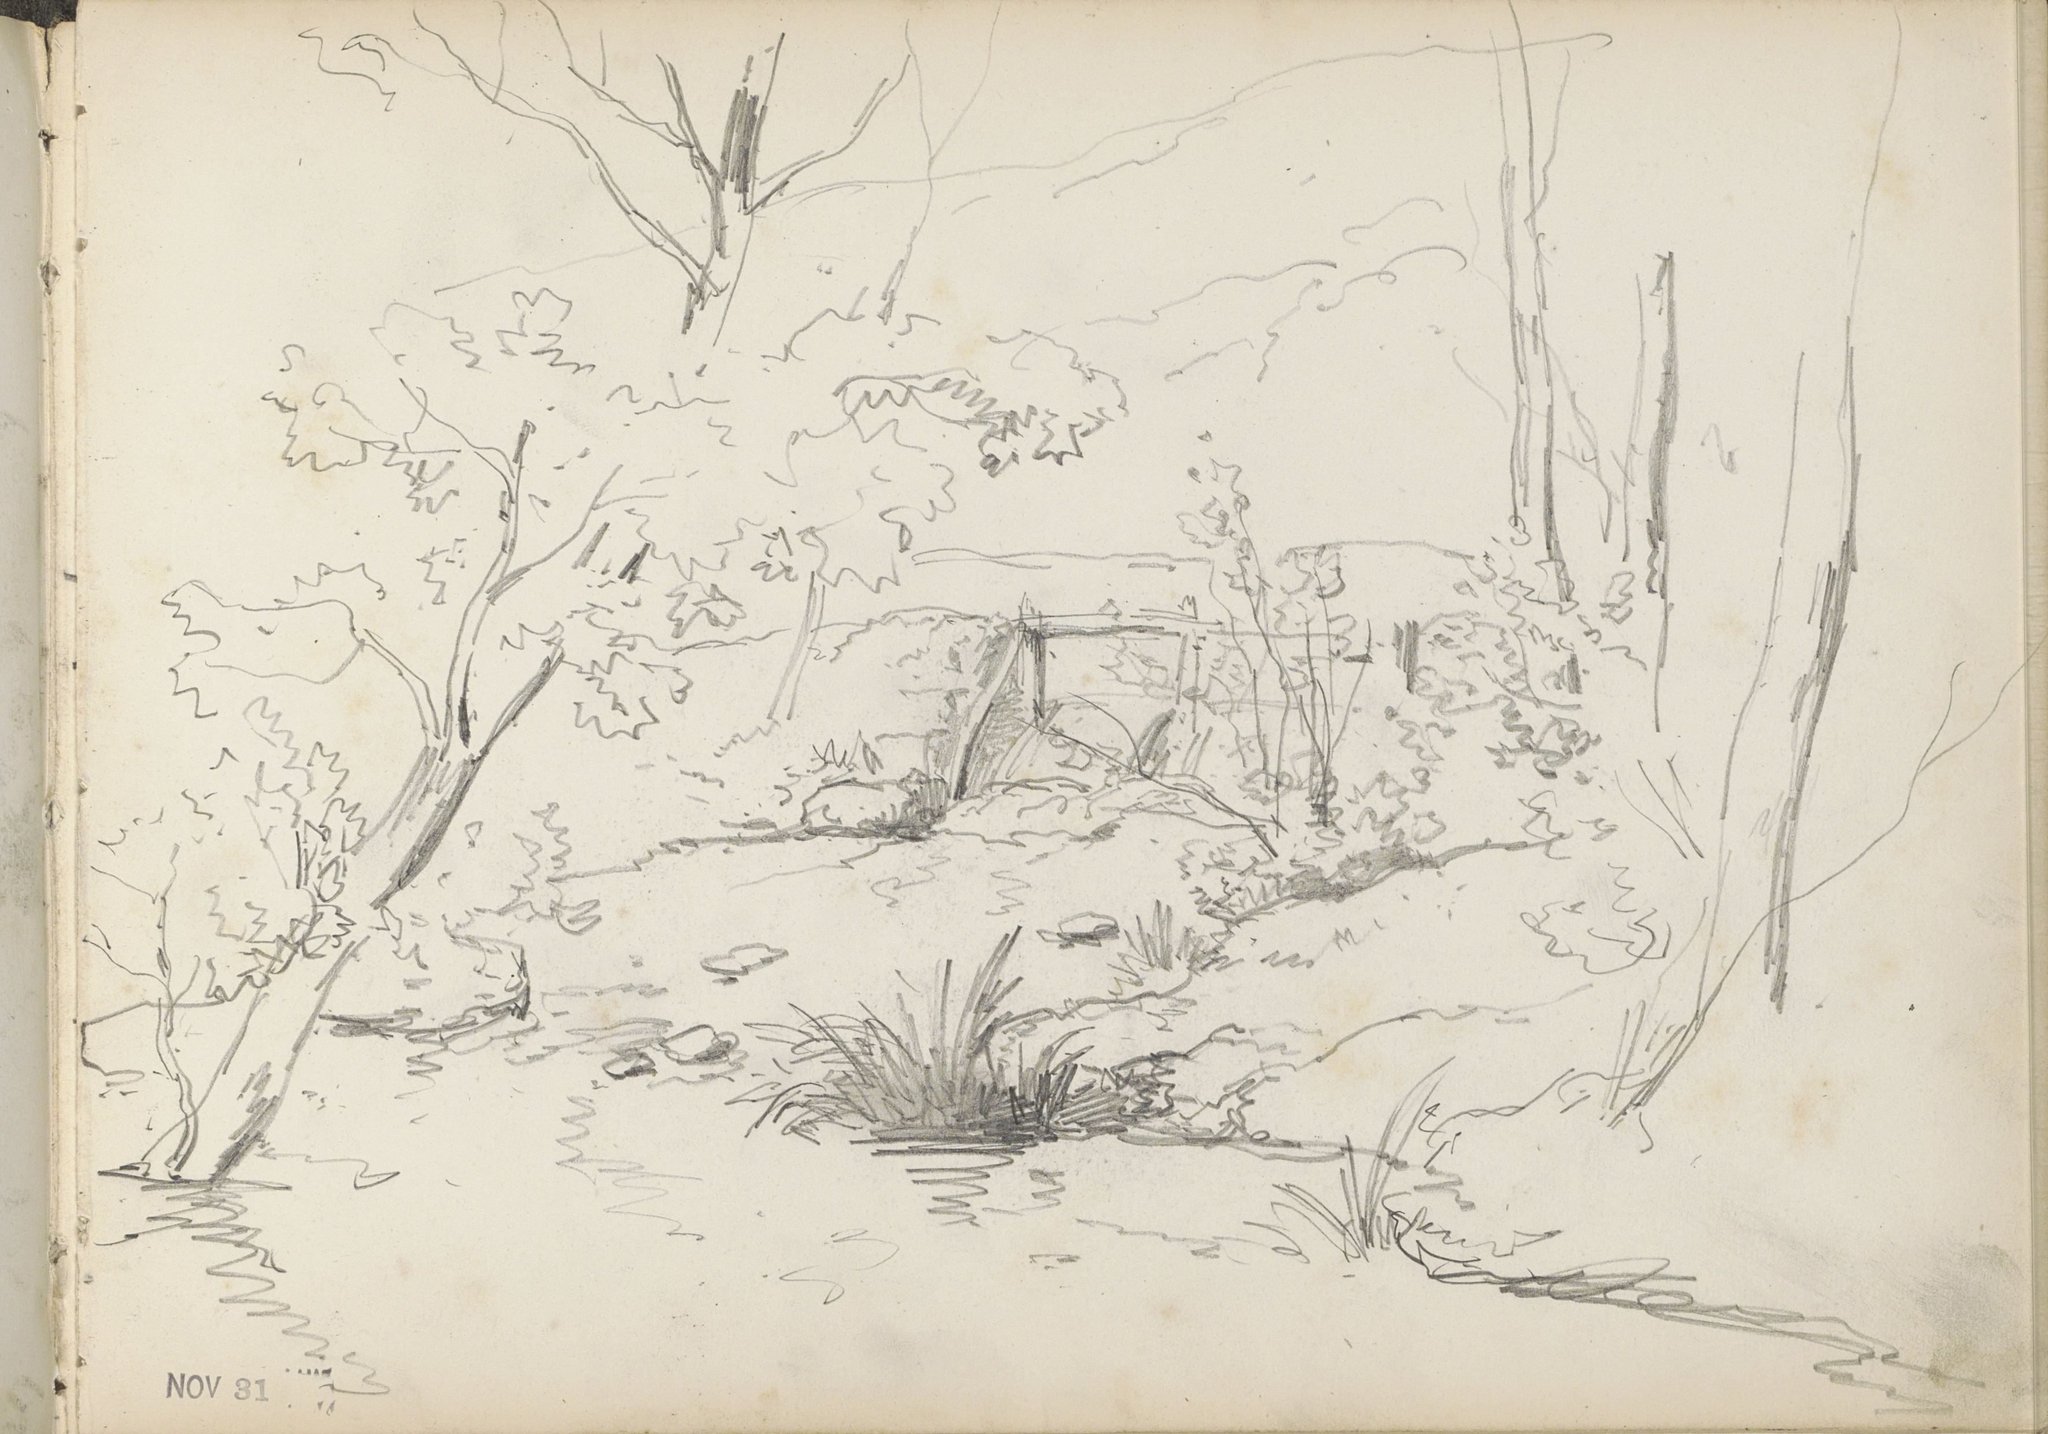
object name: sketchbook leaf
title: Landschap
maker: willem roelofs (i)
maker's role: draughtsman, painter, print maker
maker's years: 1822-1897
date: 1846-1851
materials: paper, pencil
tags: landscapes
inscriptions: date: ‘NOV 31 , ,,’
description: Blad 22 recto uit een schetsboek met 25 bladen.